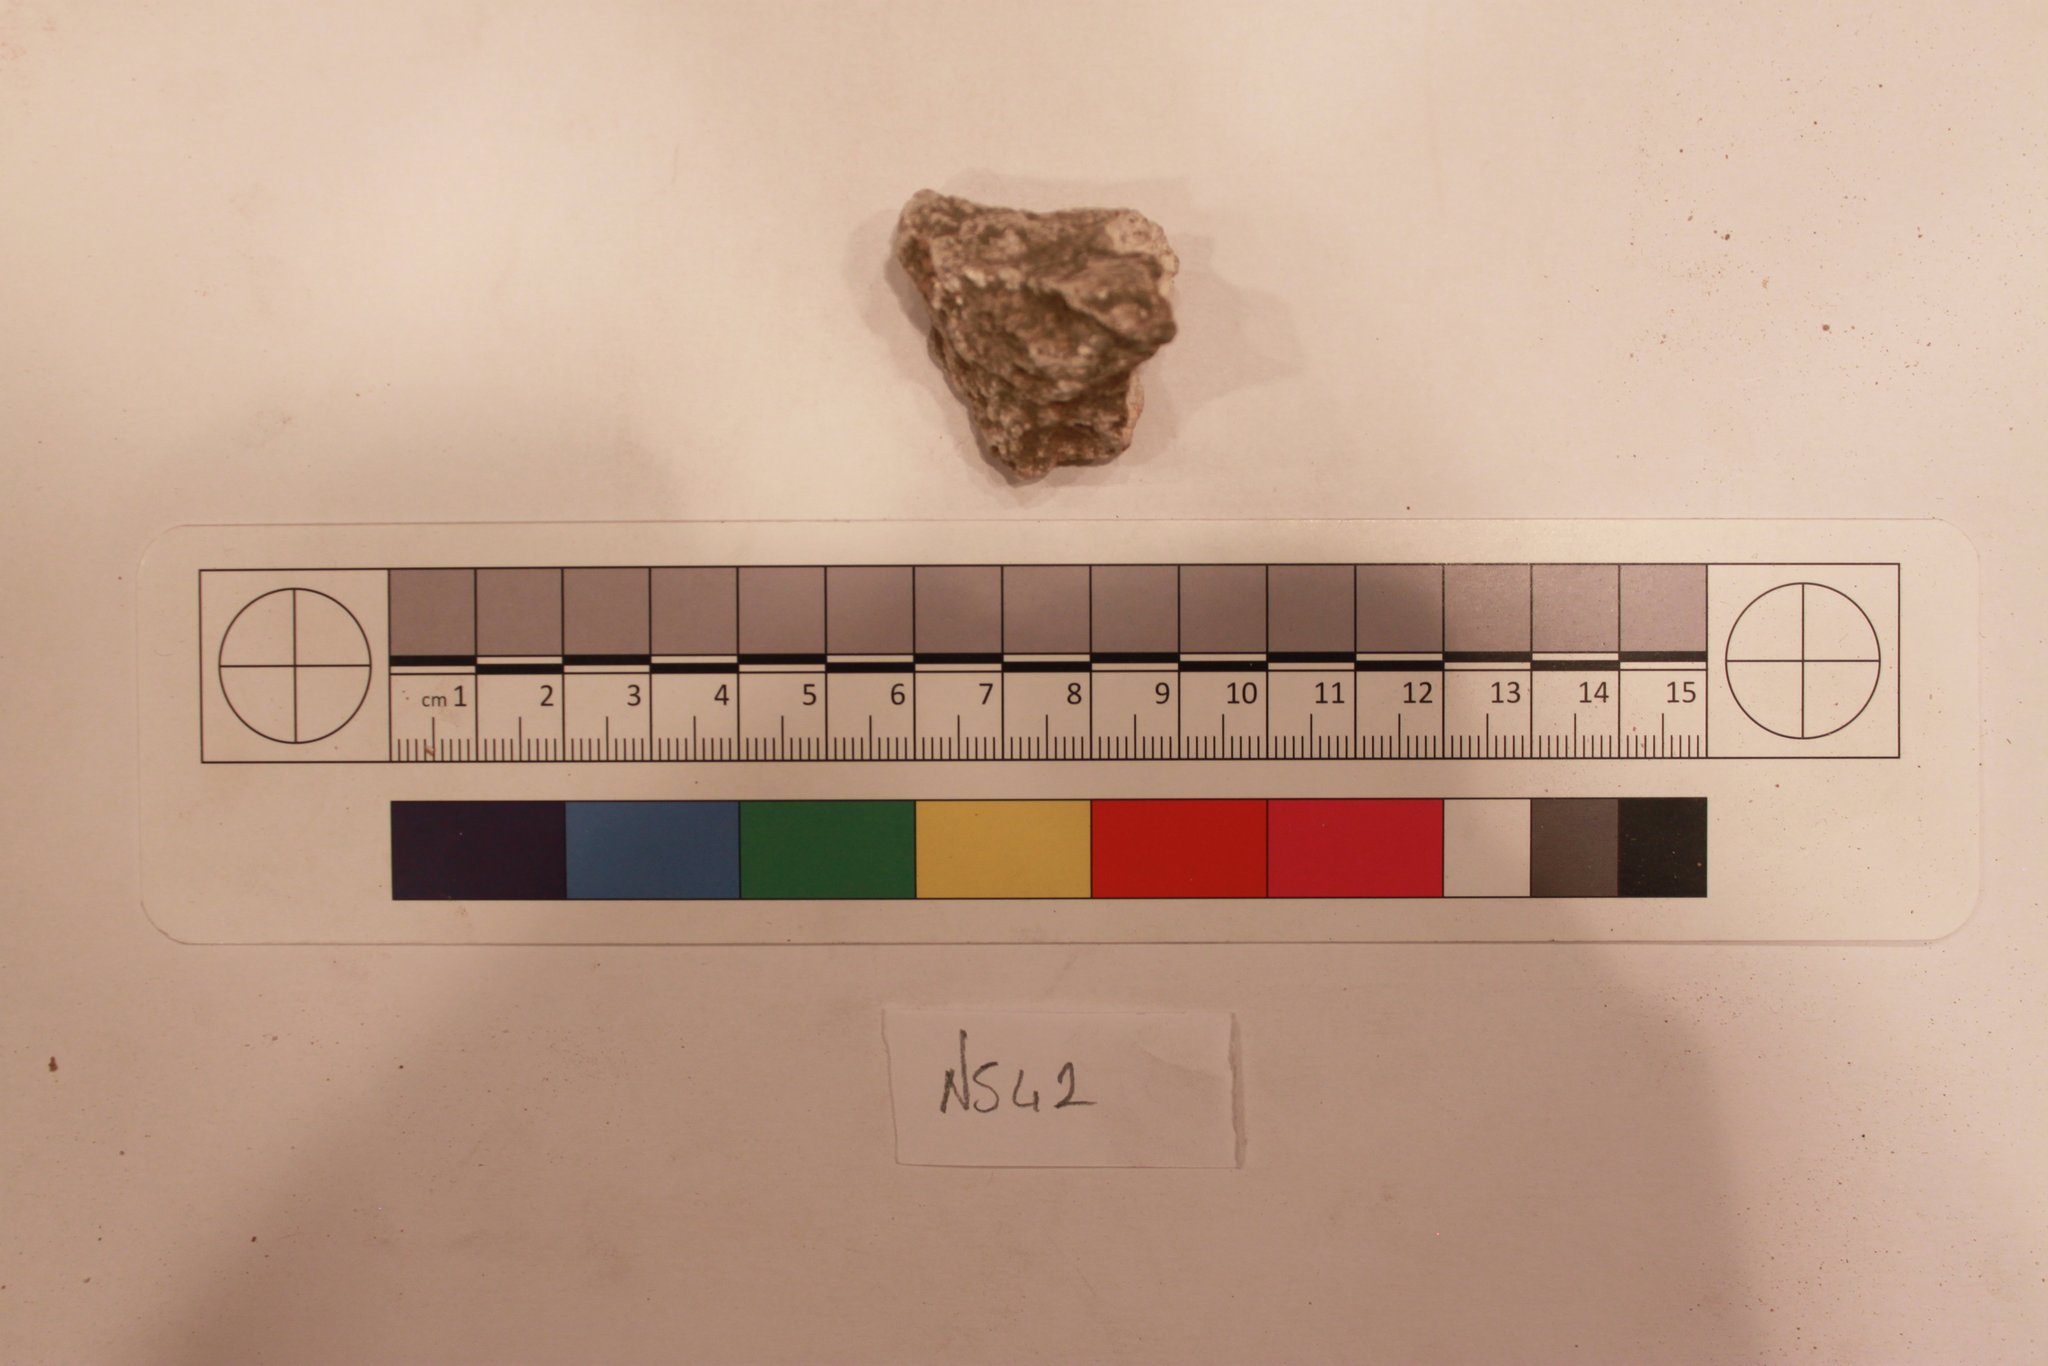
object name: fragment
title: Stucco Fragment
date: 701-1200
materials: plaster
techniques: carving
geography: iran